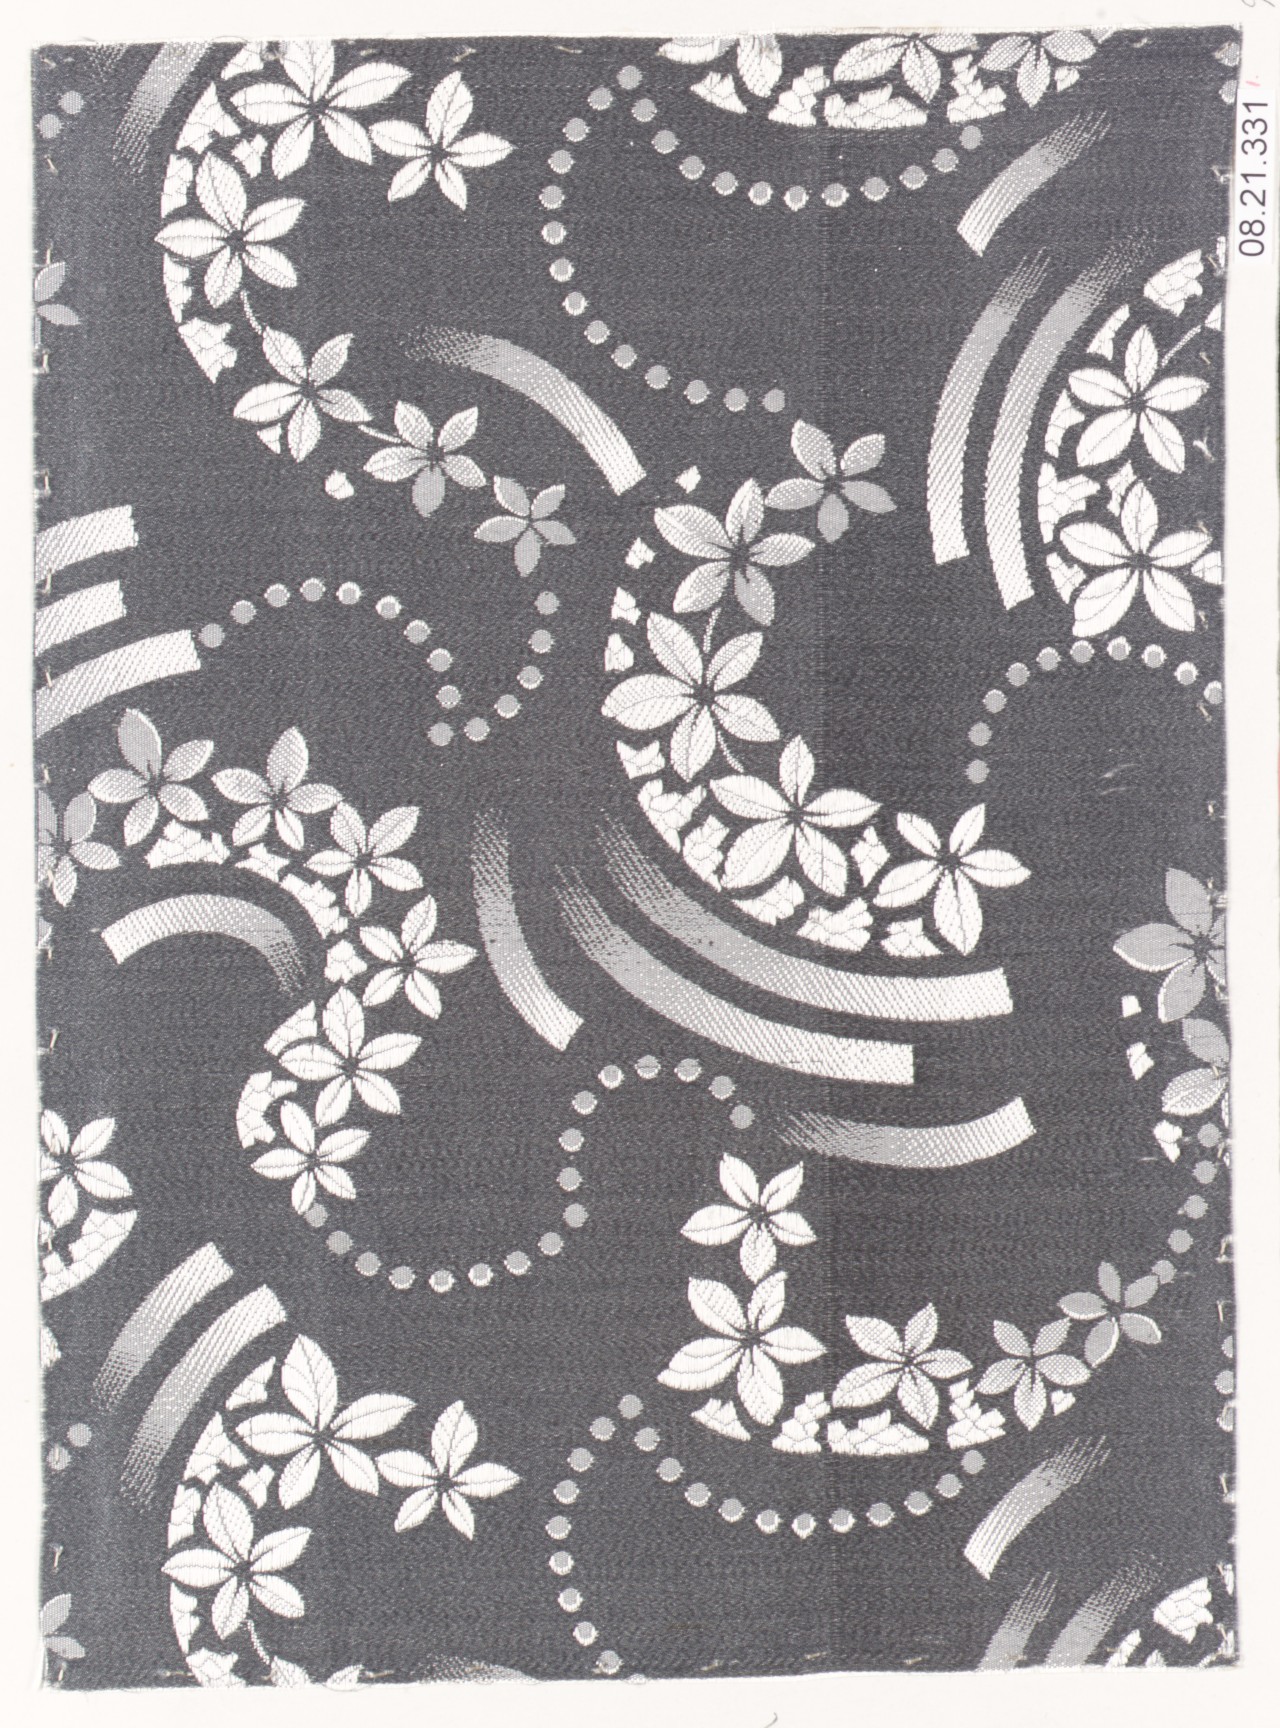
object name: textile sample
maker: Anonymous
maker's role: designer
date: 1900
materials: silk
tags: flowers